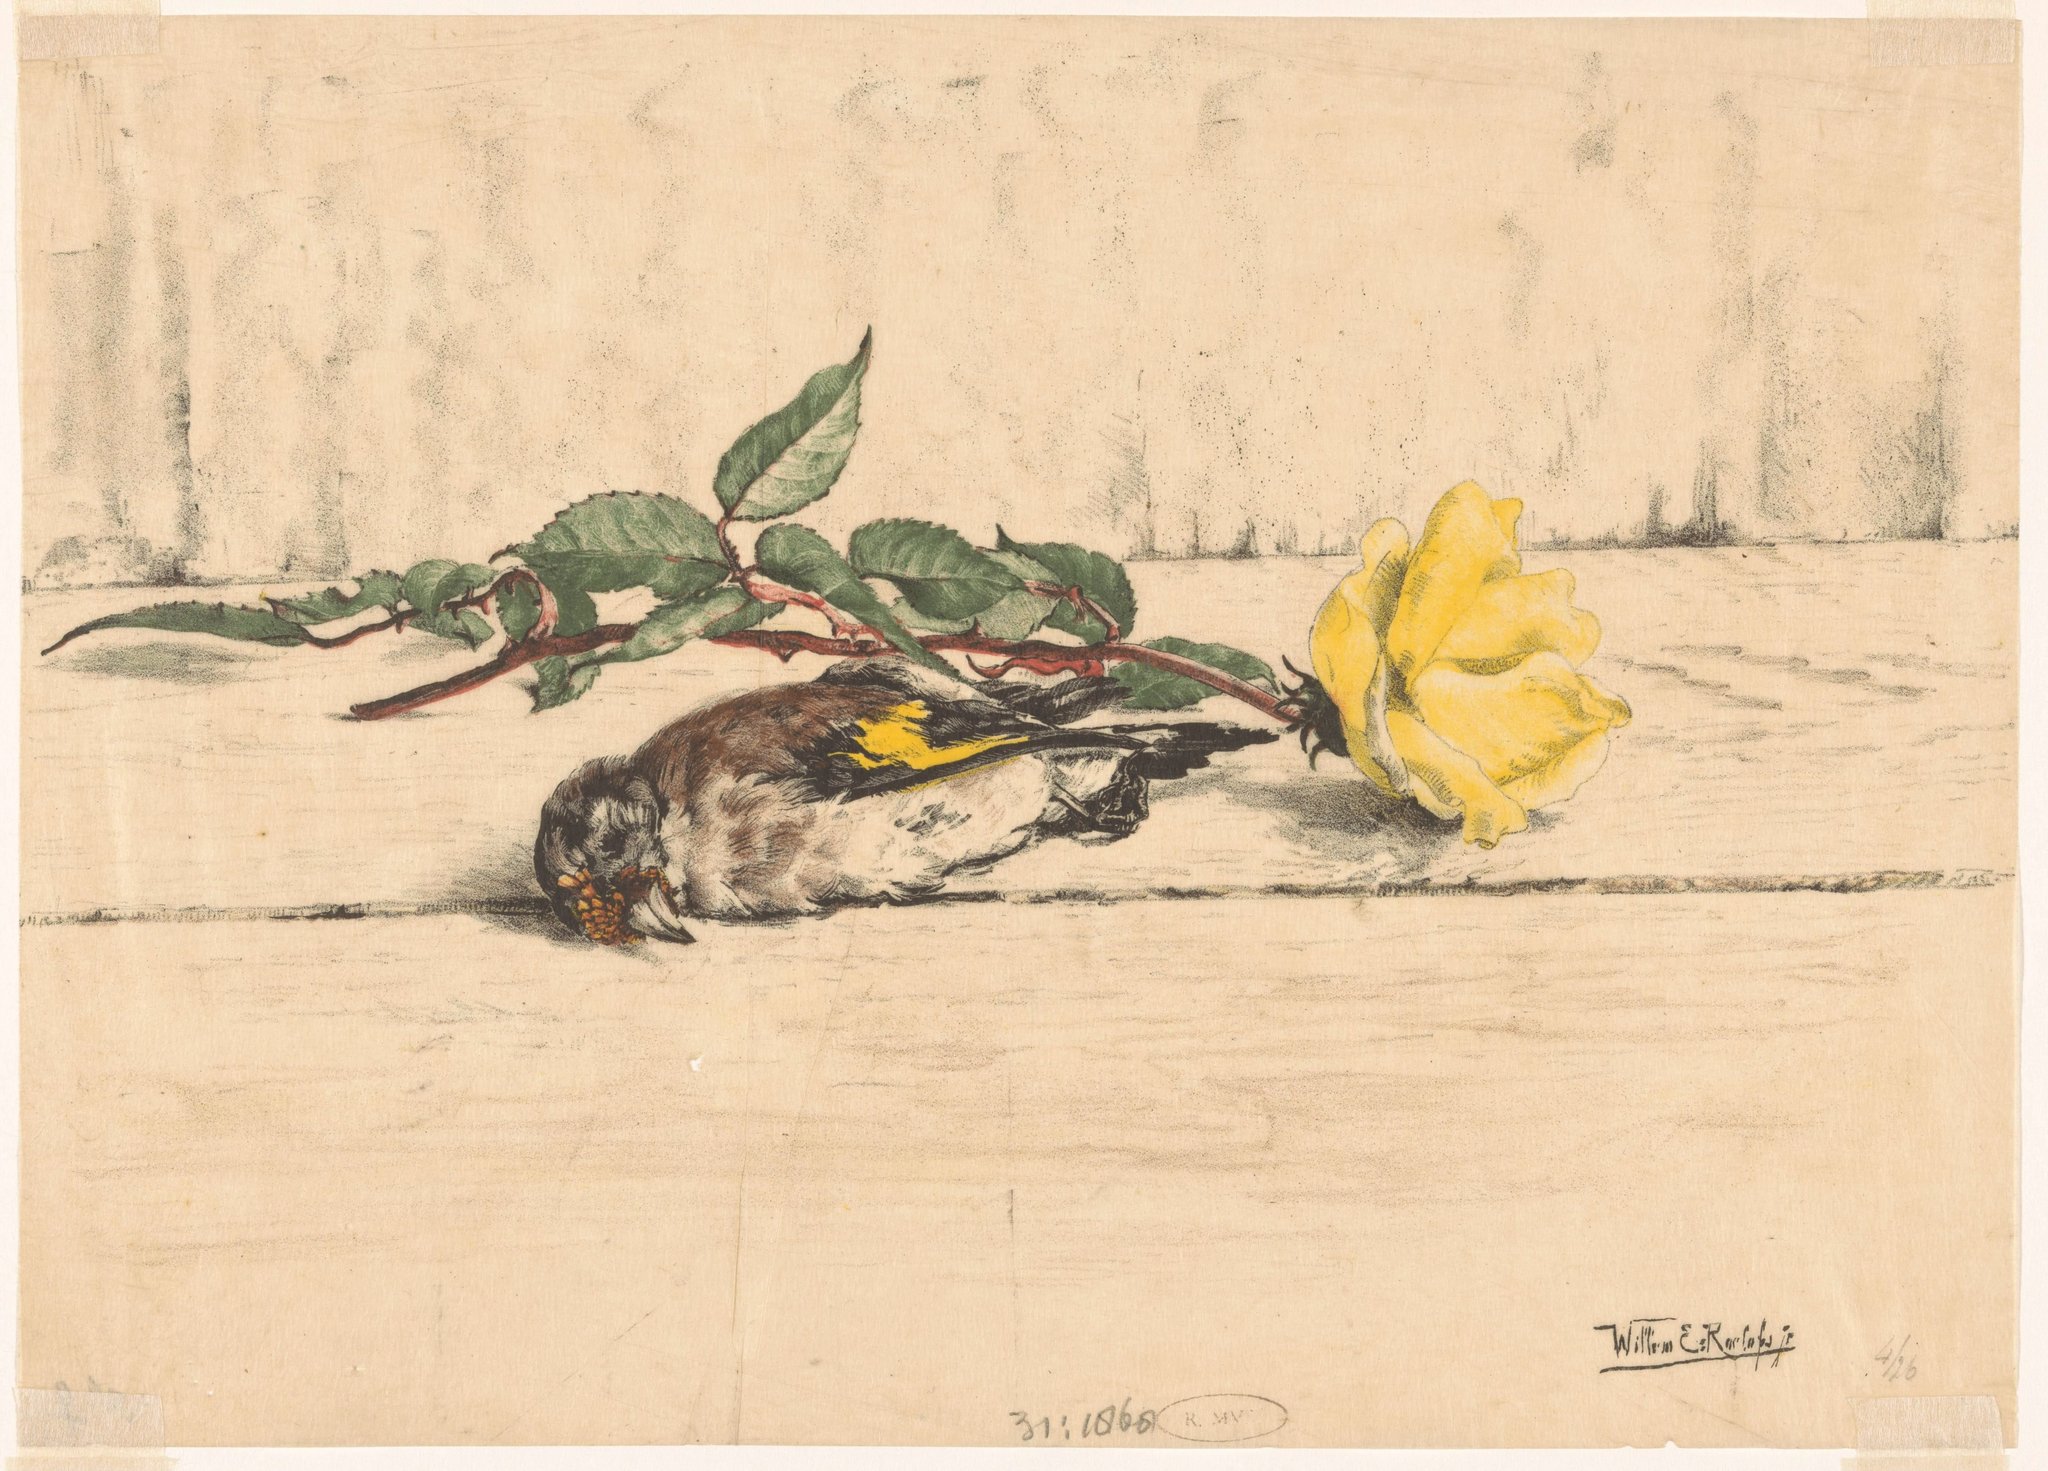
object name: print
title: Dode putter liggend naast een roos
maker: willem roelofs (ii)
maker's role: draughtsman, painter, print maker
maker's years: 1874-1940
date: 1884-1931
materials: paper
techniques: lithograph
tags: flowers: rose, birds (+ dying animal; death of animal; dead animal), song-birds: goldfinch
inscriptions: collector's mark: Lugt 2228